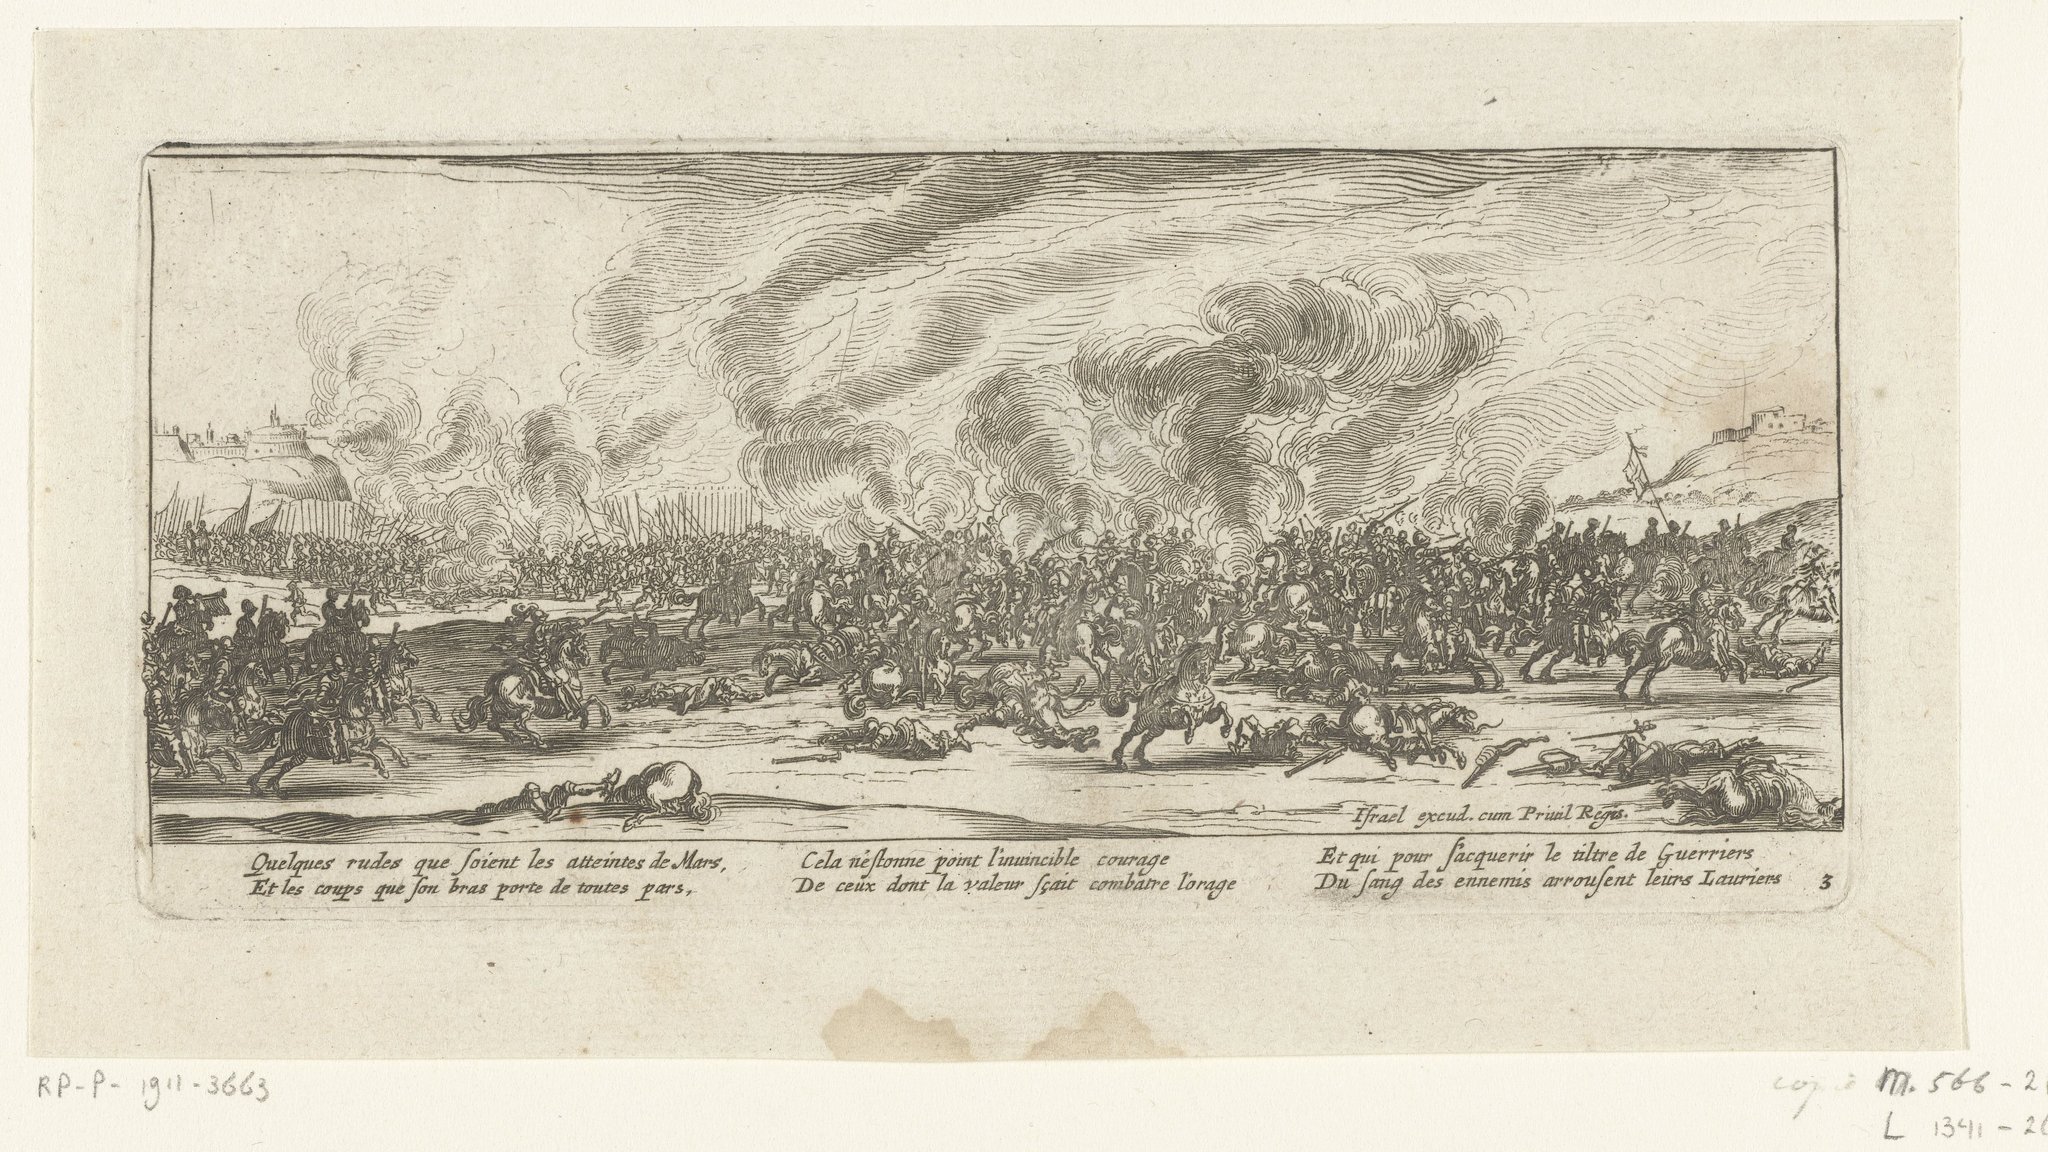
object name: print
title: De gruwelen van de oorlog (groot)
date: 1677-1690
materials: paper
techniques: etching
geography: netherlands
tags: land forces, battle, warfare; military affairs (+ cavalry, horsemen), warfare; military affairs (+ infantry)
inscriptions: collector's mark: Lugt 2228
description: Op een veld strijden vele ruiters met elkaar. Op de achtergrond is tevens een gevecht tussen infanteristen zichtbaar. Onder de voorstelling een zesregelig Frans vers. Deze prent is onderdeel van een serie van 17 (18 incl. titelprent) prenten met voorstellingen van diverse soorten ellende die oorlogvoering met zich meebrengt.